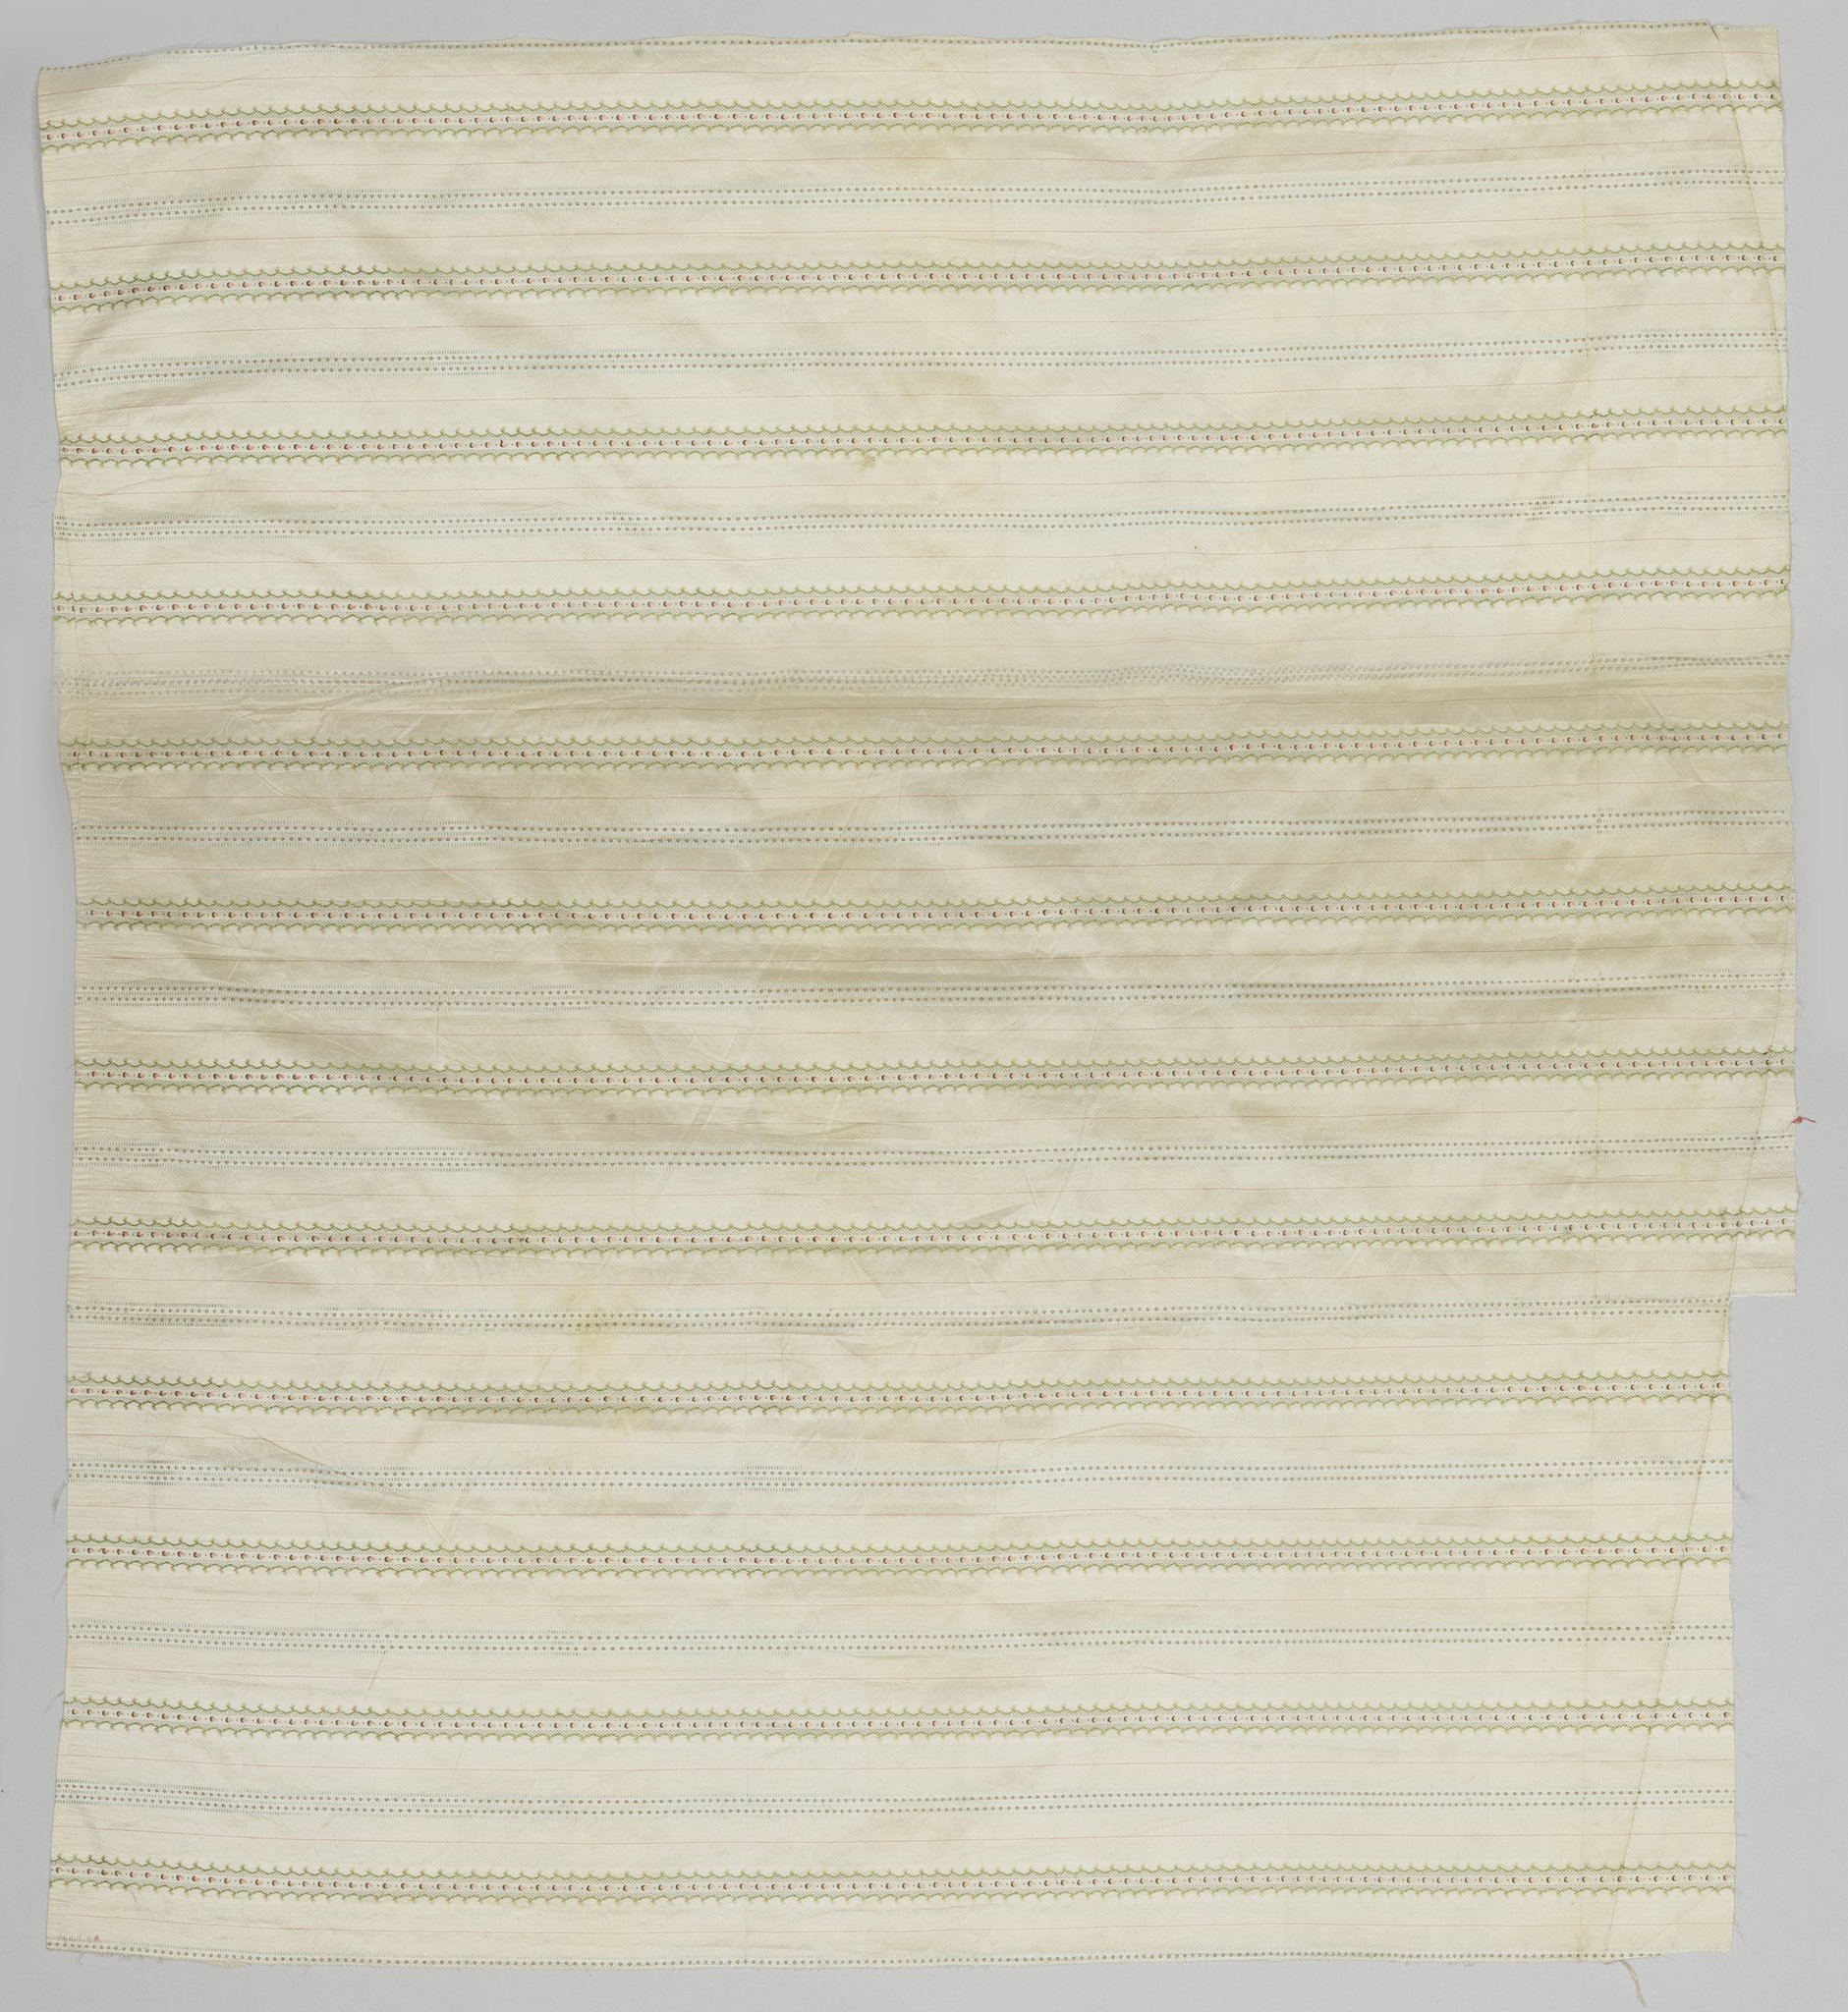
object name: fragment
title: Fragment gestreepte, veelkleurige zijden mexicaine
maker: Anonymous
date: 1775-1800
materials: silk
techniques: mexicaine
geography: netherlands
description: Fragment witte zijde met gekleurde strepen (vermoedelijk mouwgarneersel). Opmerking: Zelfkant; 5 mm in effenbinding. Bestaat uit drie banen van 44.5 cm. Zelfkanten aan de binnenzijde plus één zelfkant rechts naar binnen gevouwen.